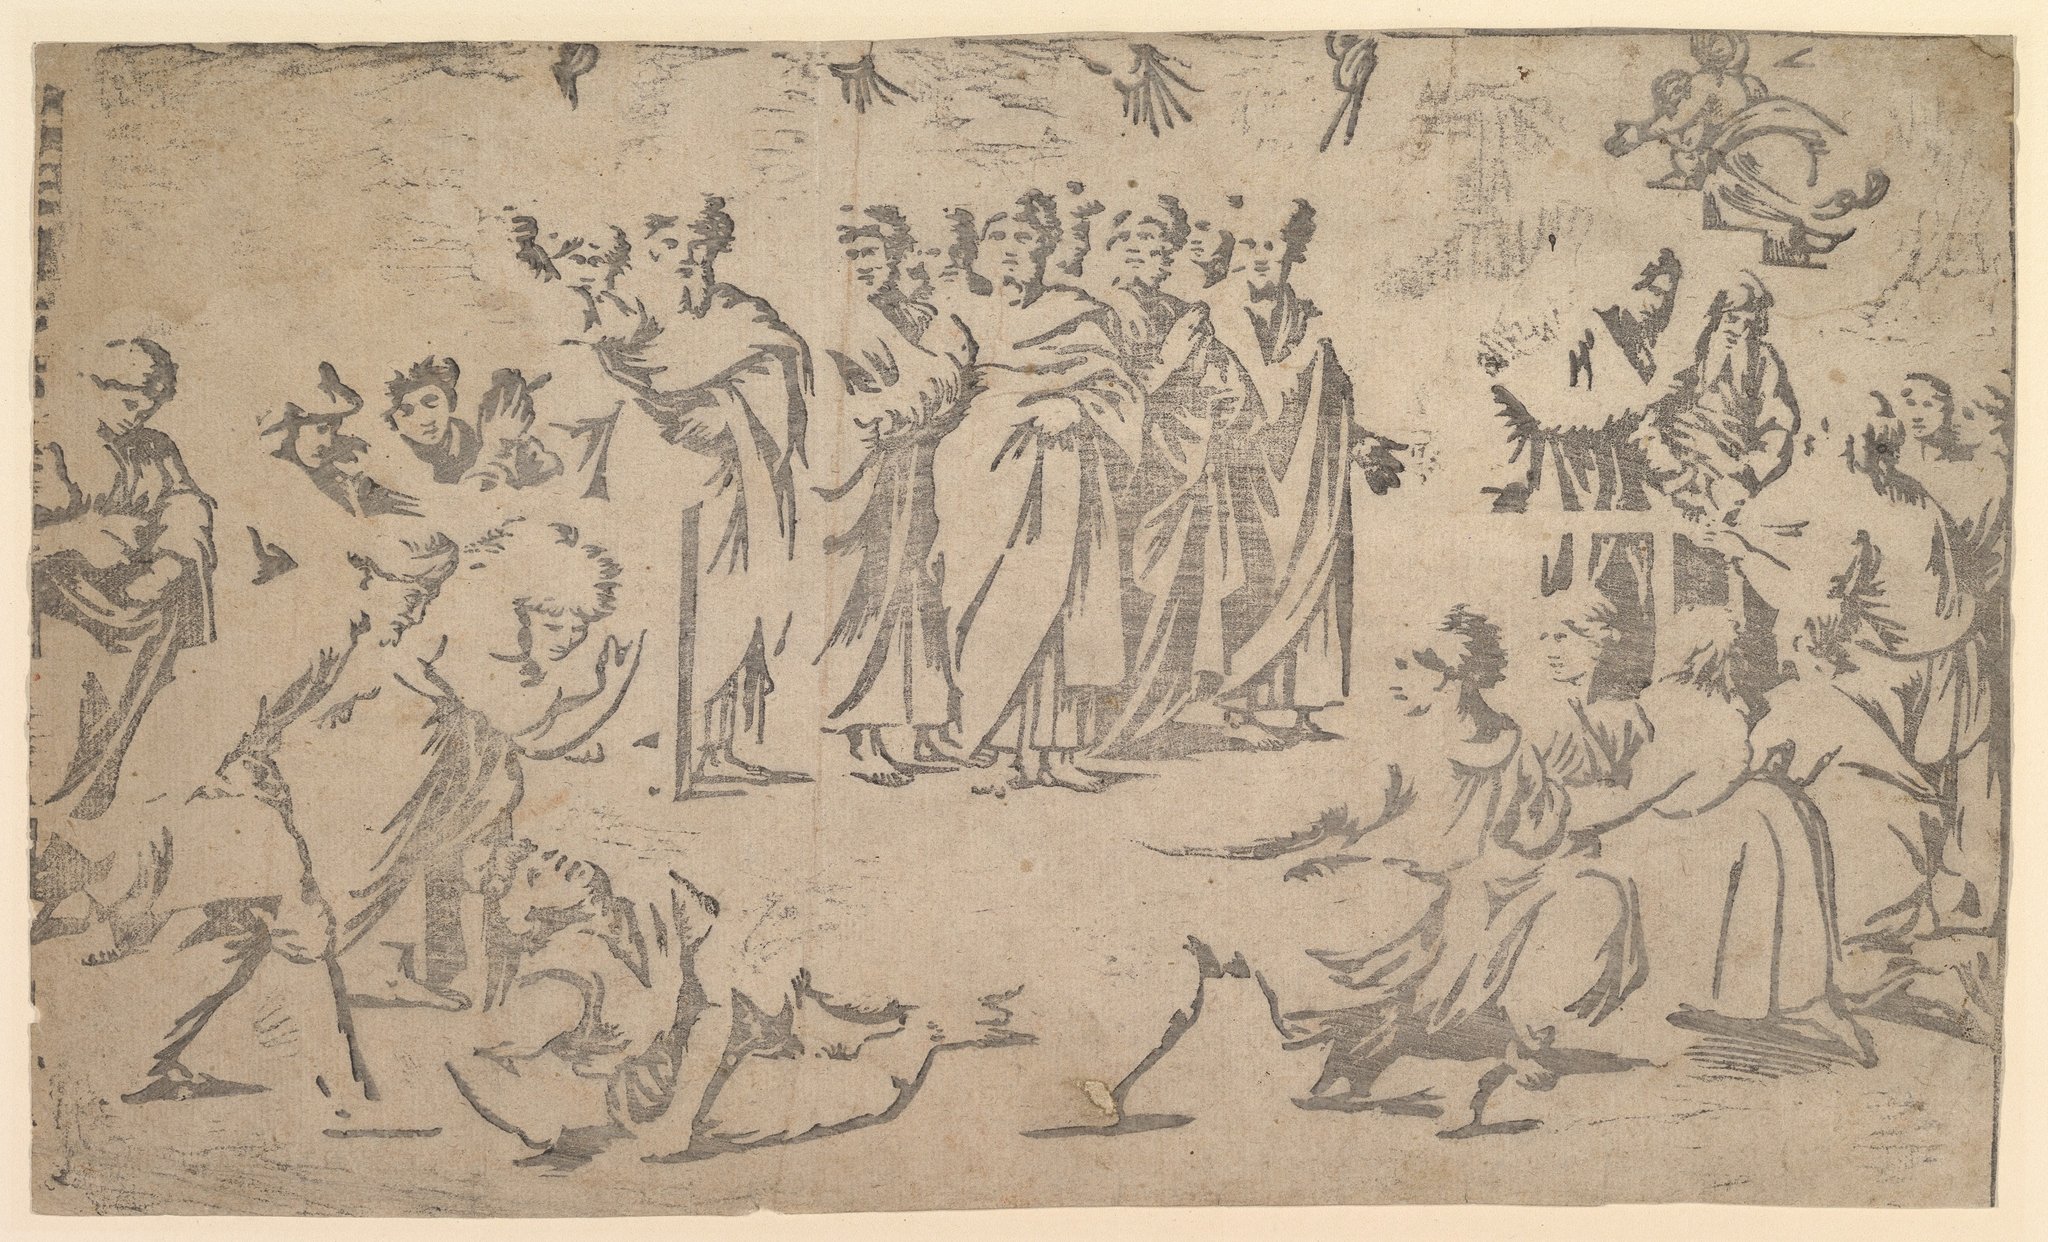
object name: print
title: The death of Ananias surrounded by Apostles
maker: ugo da carpi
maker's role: artist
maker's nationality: italian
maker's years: 1480-1532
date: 1518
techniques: woodcut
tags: men,apostles